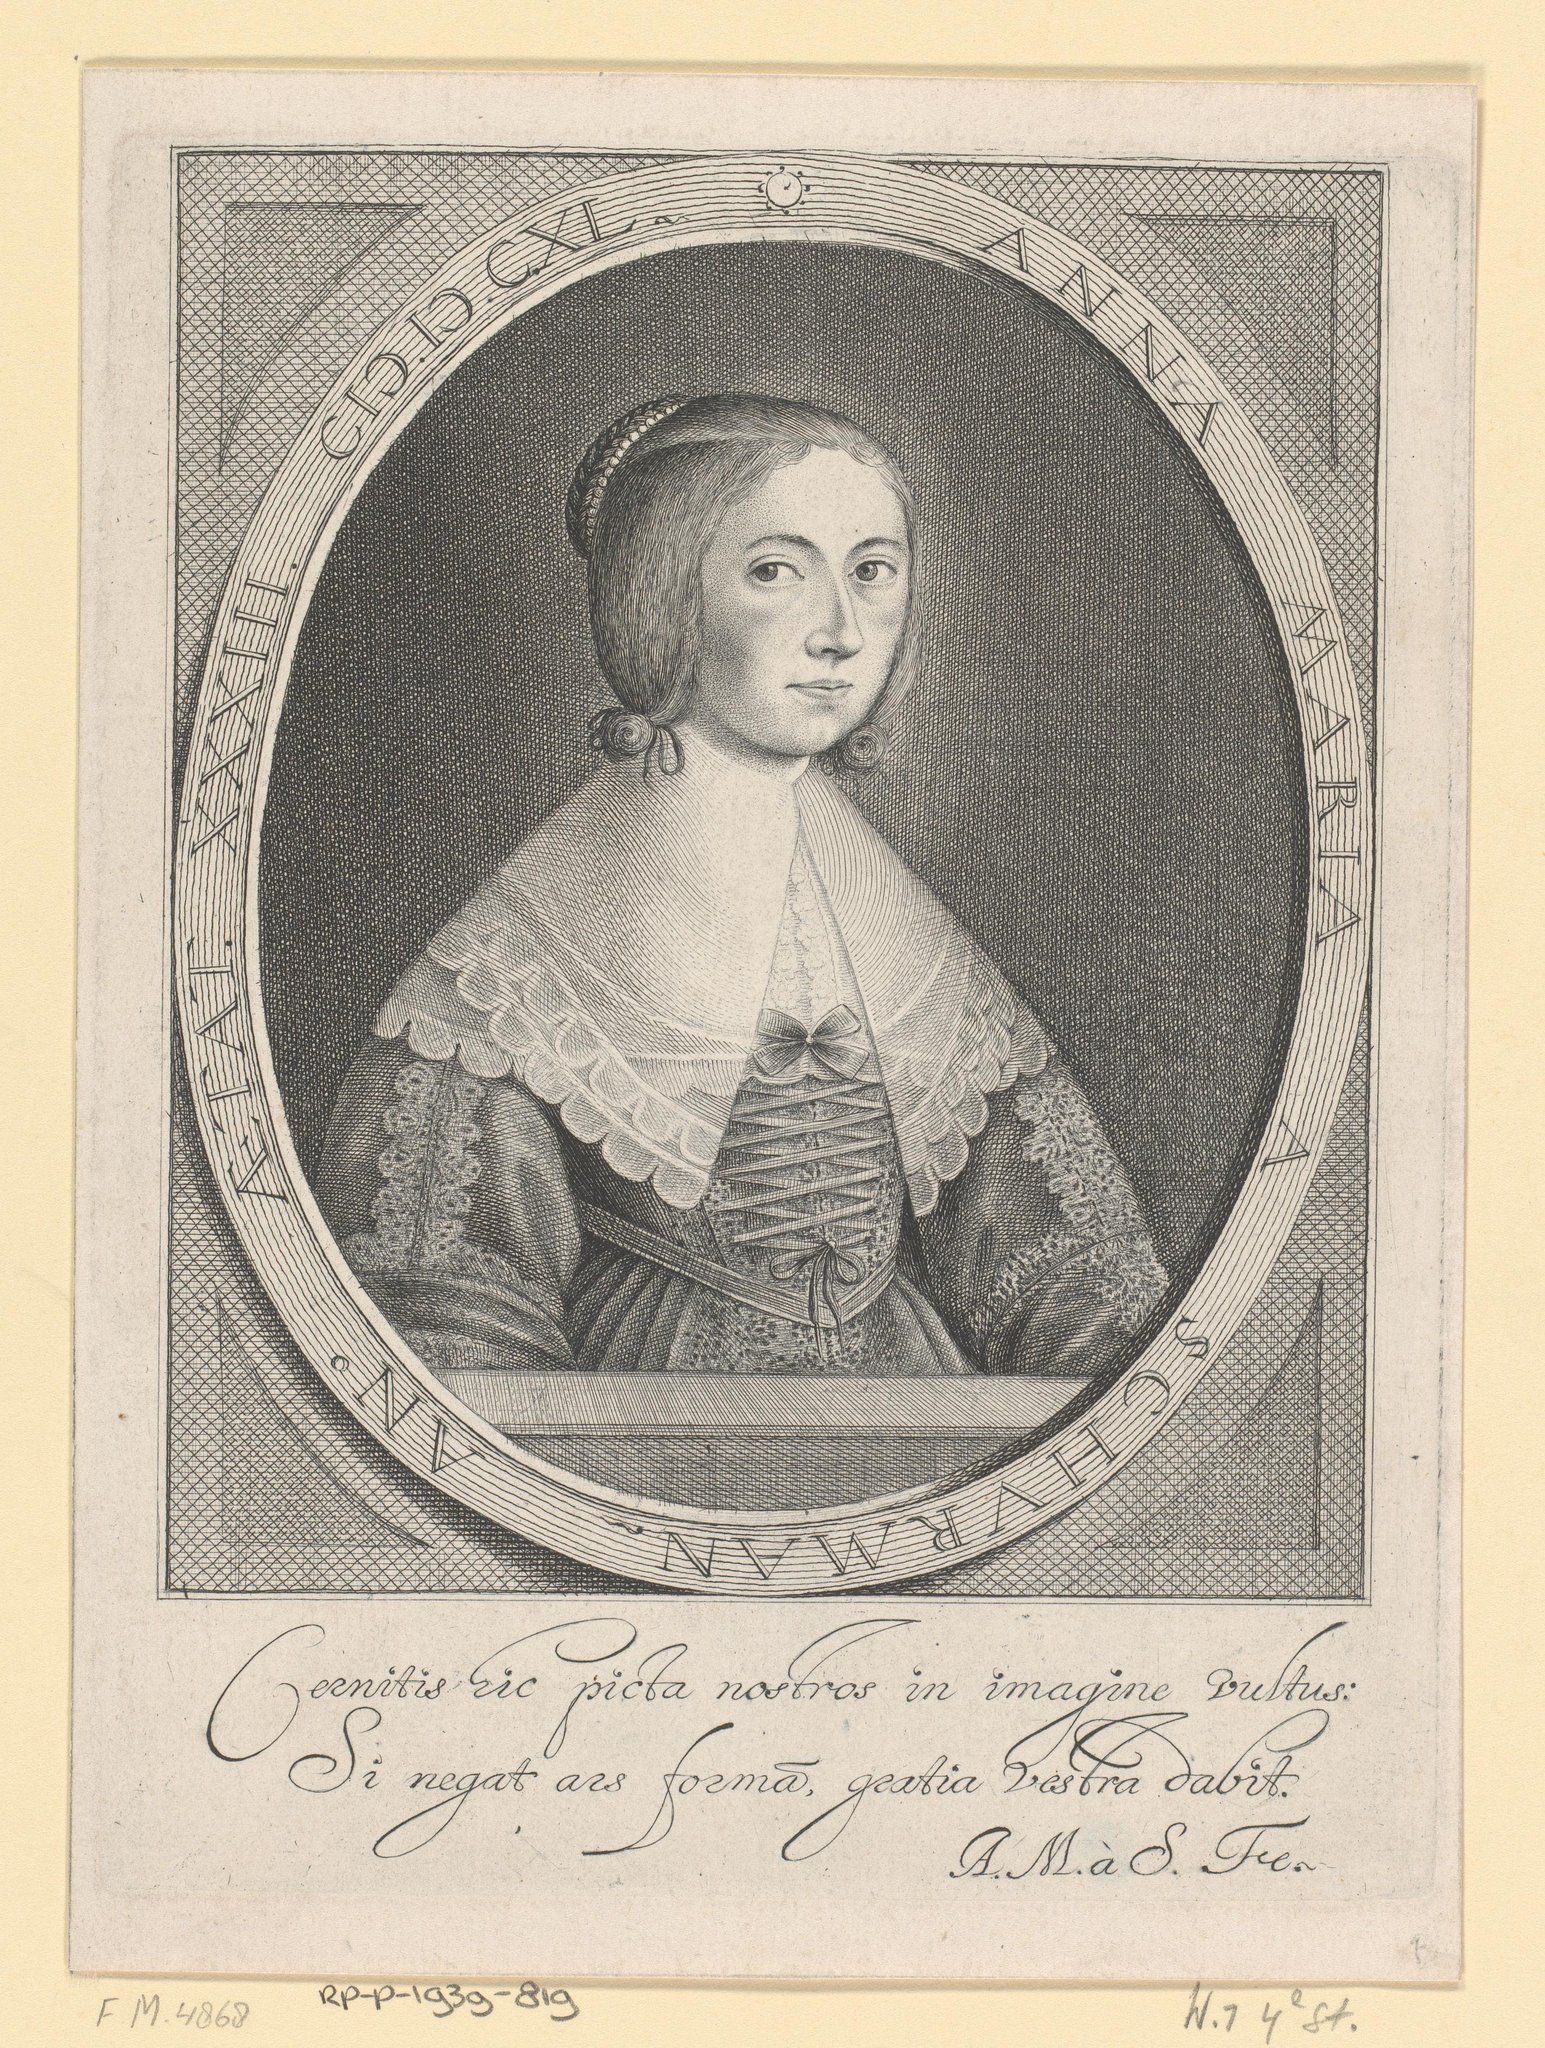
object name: print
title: Zelfportret op 33-jarige leeftijd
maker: anna maria van schurman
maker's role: draughtsman, print maker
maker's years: 1607-1678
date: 1640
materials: paper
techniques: engraving, etching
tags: cologne, print maker, draughtsman, anna maria van schurman, historical persons - bb - woman, portrait, self-portrait of artist, writer, poet, author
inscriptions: collector's mark: Lugt 2166, collector's mark: Lugt 2760, collector's mark: Lugt 1337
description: Met tweeregelig onderschrift in het Latijn en tekst in het Latijn rondom het portret.